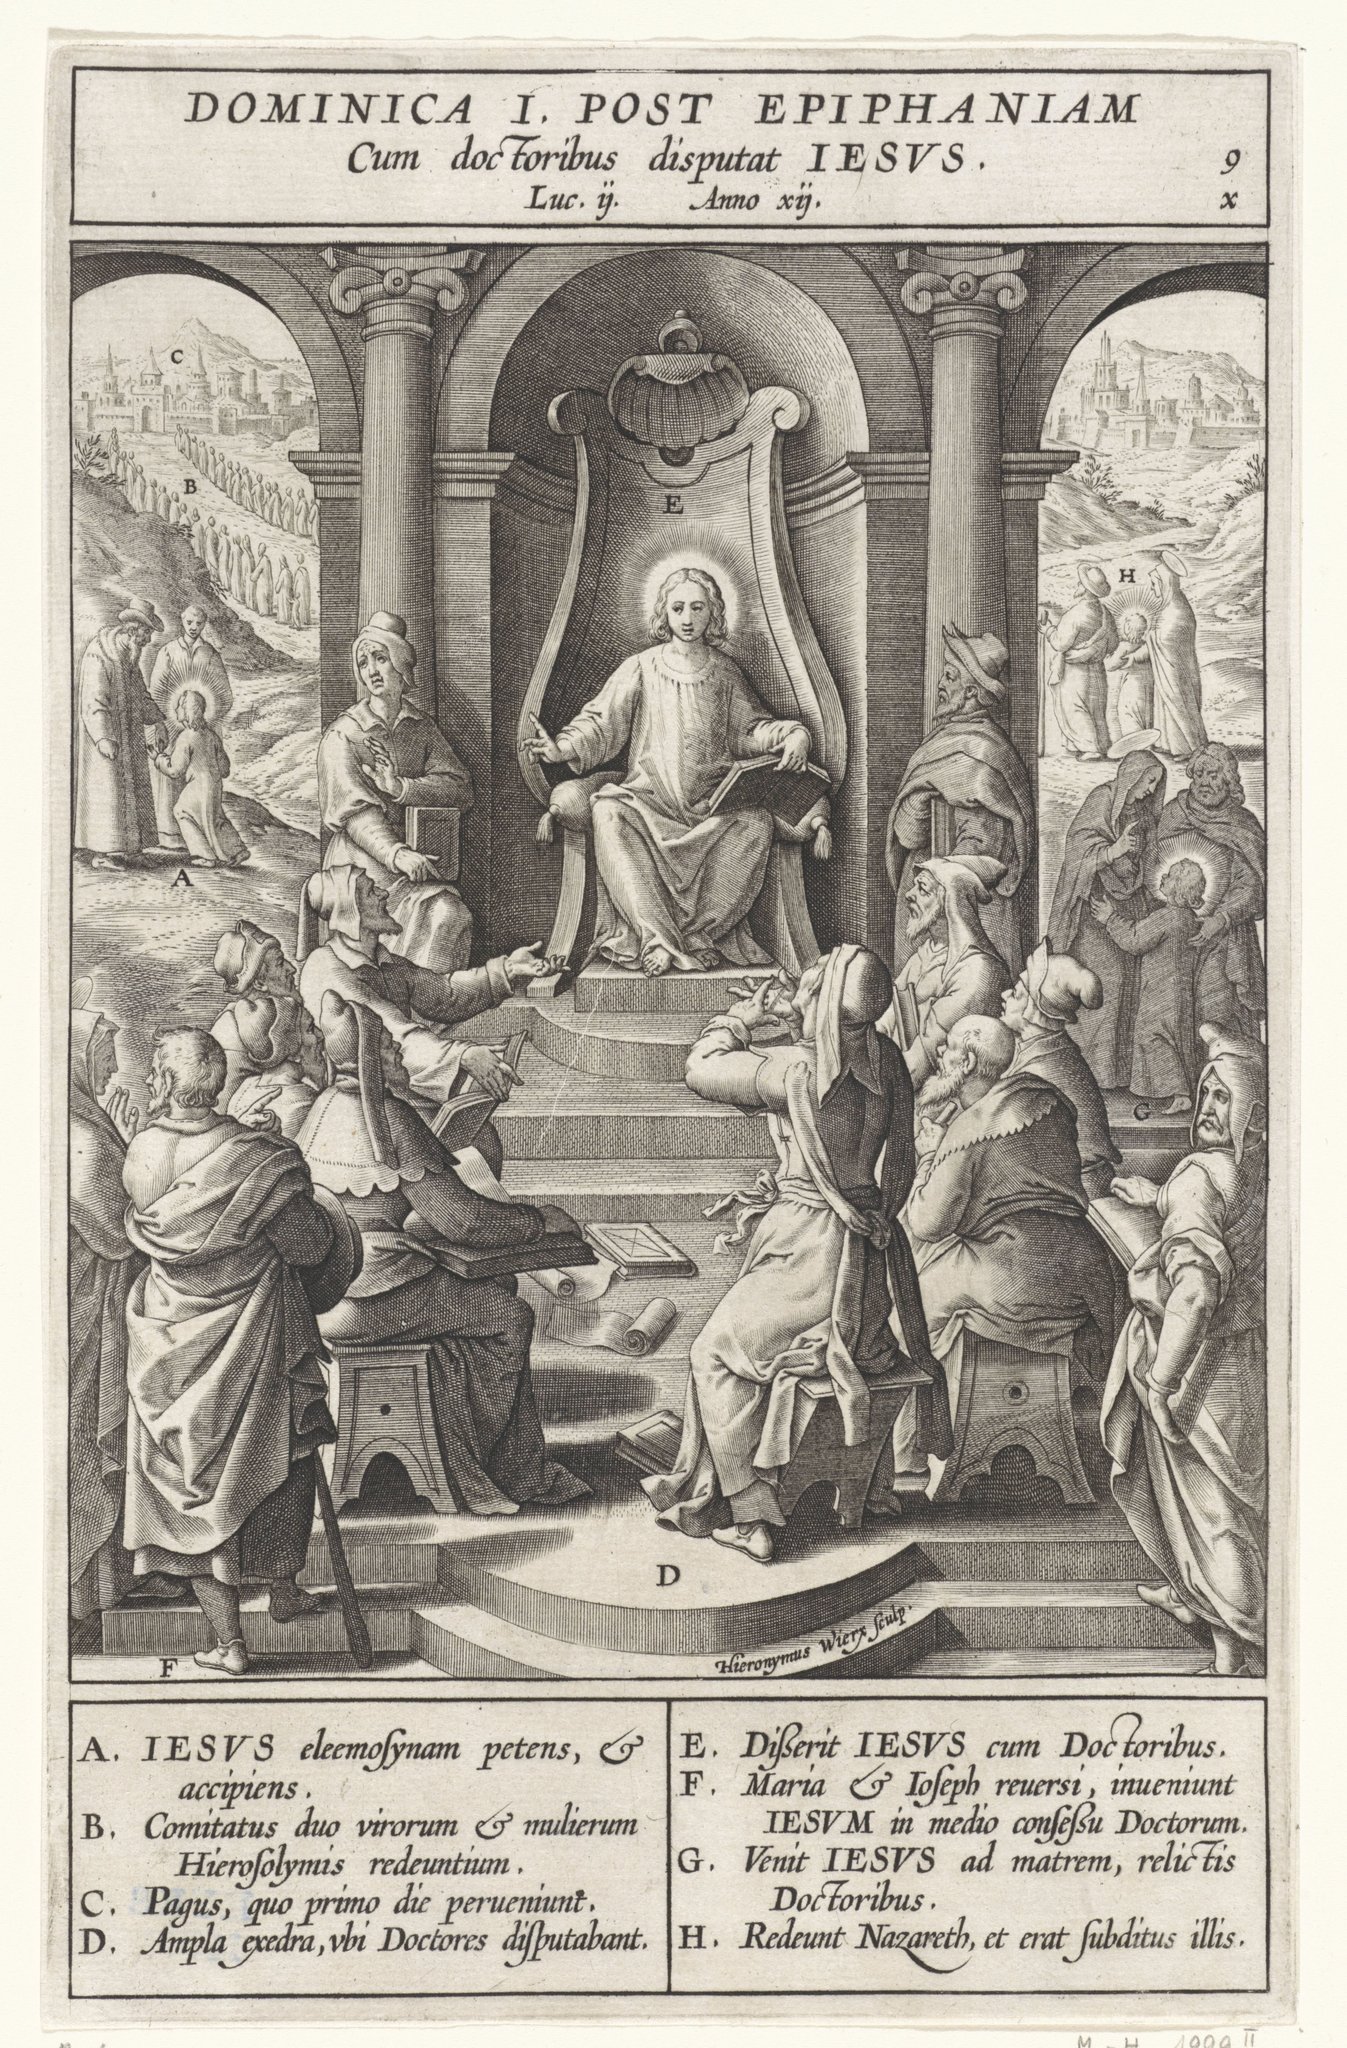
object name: print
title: Dominica I. Post Epiphaniam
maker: hieronymus wierix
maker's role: draughtsman, print maker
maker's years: 1553-1619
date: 1593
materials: paper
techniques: engraving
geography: antwerp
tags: christ's dispute with the doctors in the temple; he counts his arguments on his fingers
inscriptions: collector's mark: Lugt 2165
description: Christus zit in de tempel op een troon. Hij legt de schrift uit aan de schriftgeleerden. Jozef en Maria lopen de tempel binnen en vinden hun twaalfjarige zoon tussen de geleerden. Bij verschillende elementen uit de voorstelling staan letters die corresponderen met de legenda in de marge.